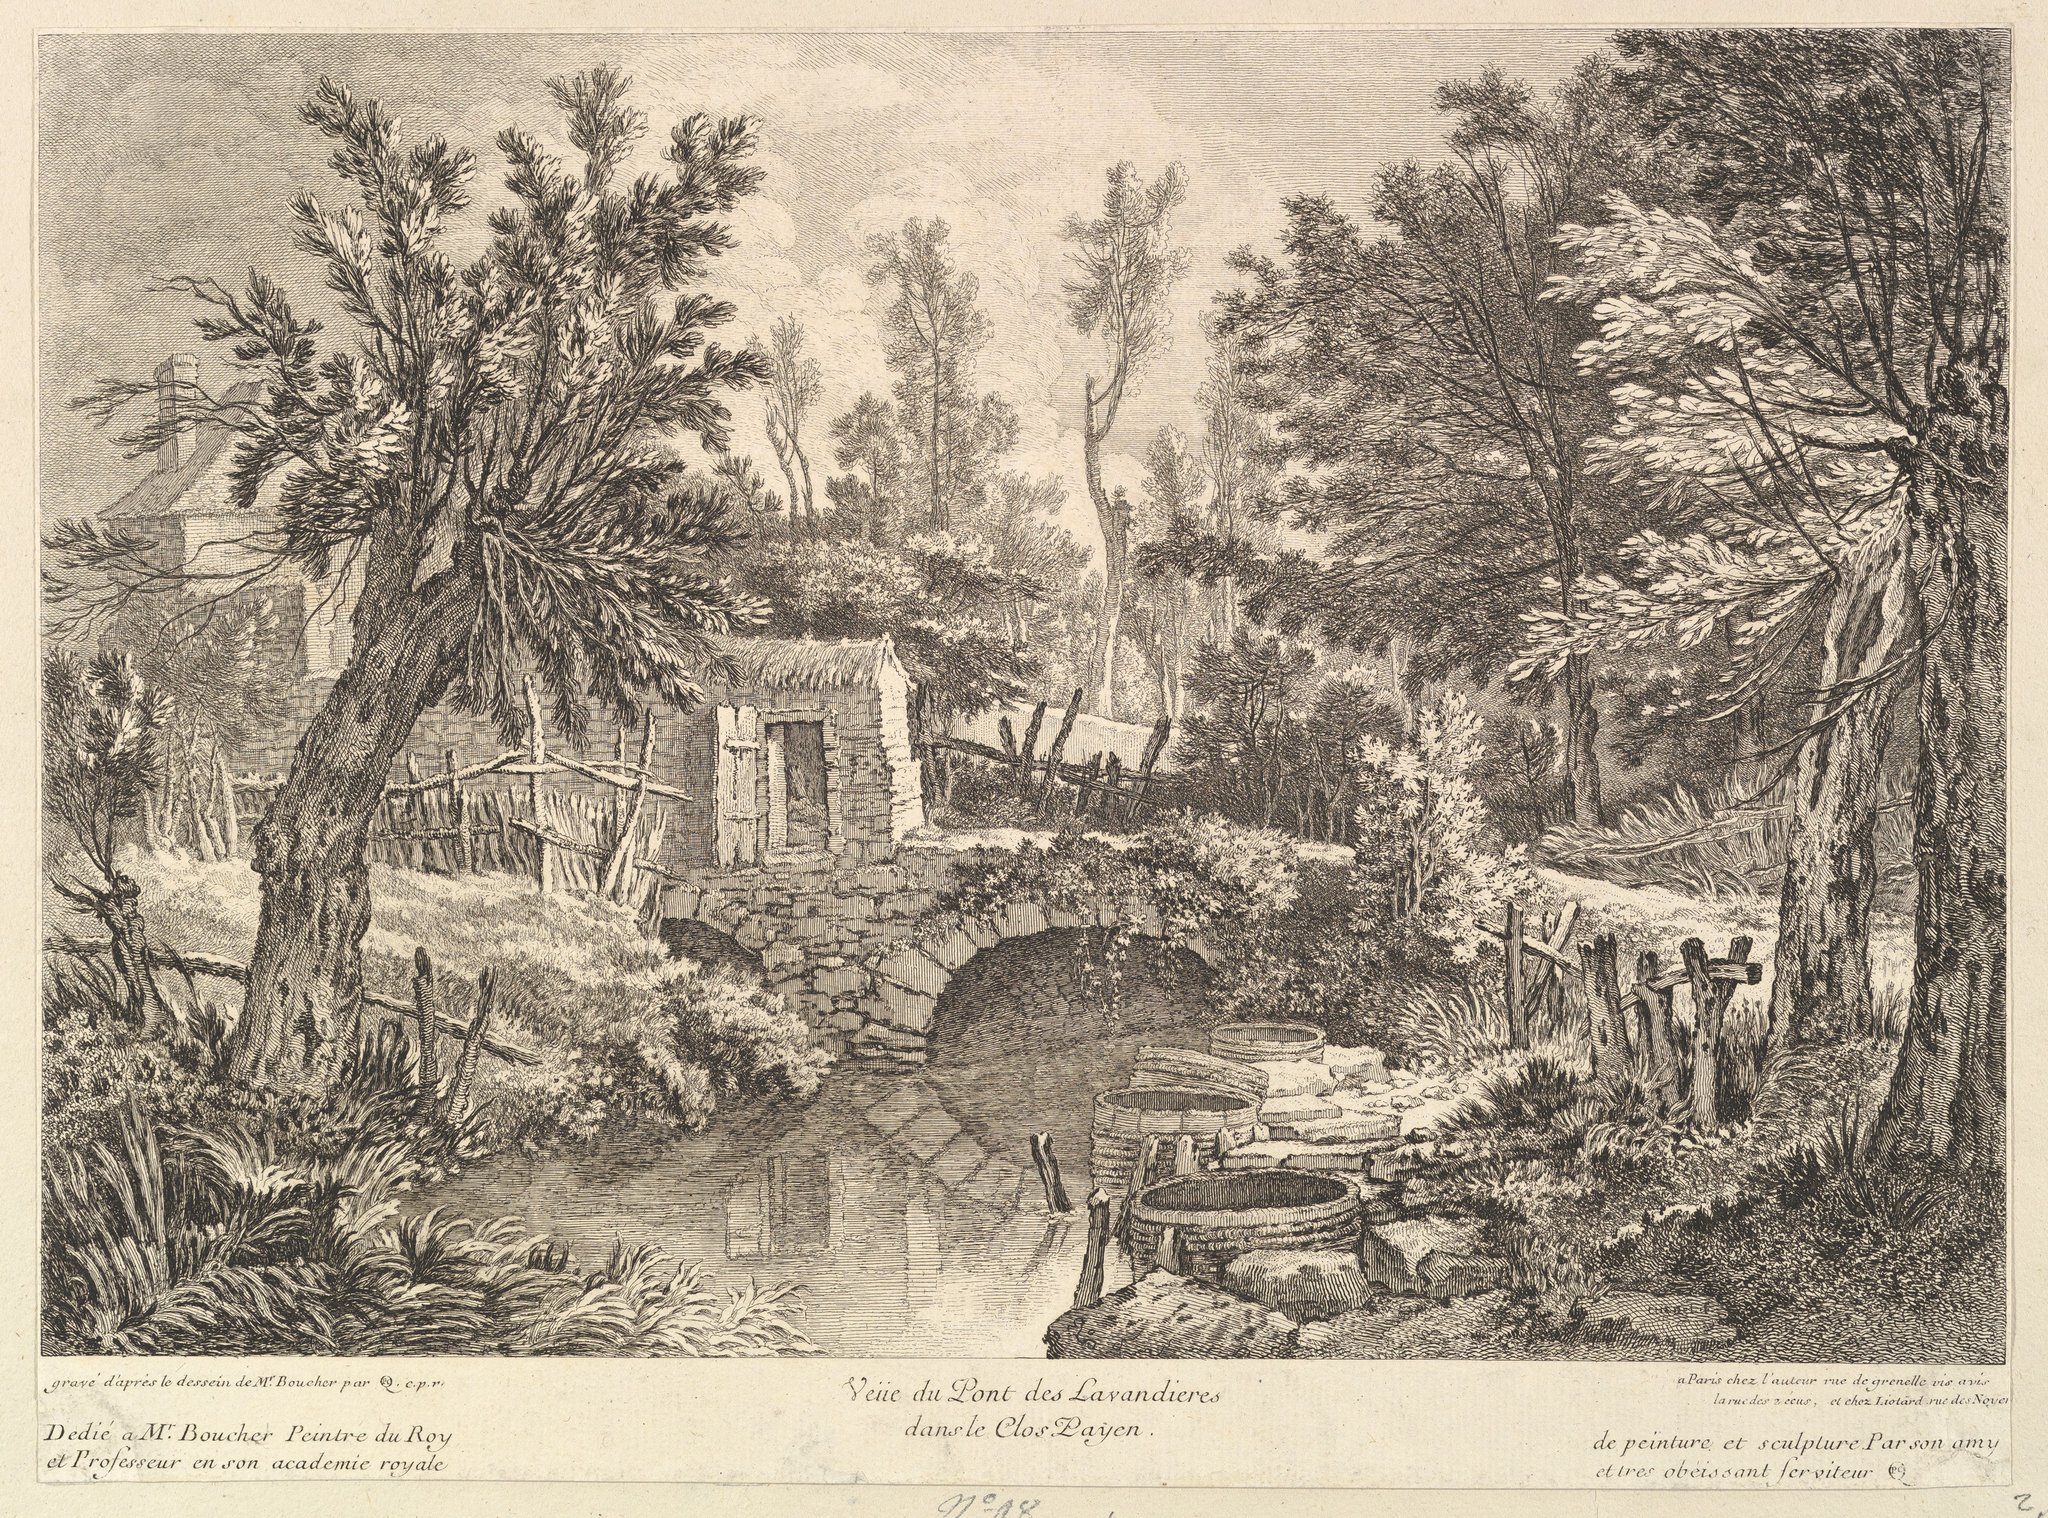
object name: print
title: View of the Bridge of Washerwomen at the Peasant House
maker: quentin pierre chedel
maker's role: artist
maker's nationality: french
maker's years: 1705-1763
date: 1734-1766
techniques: etching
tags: bridges,trees